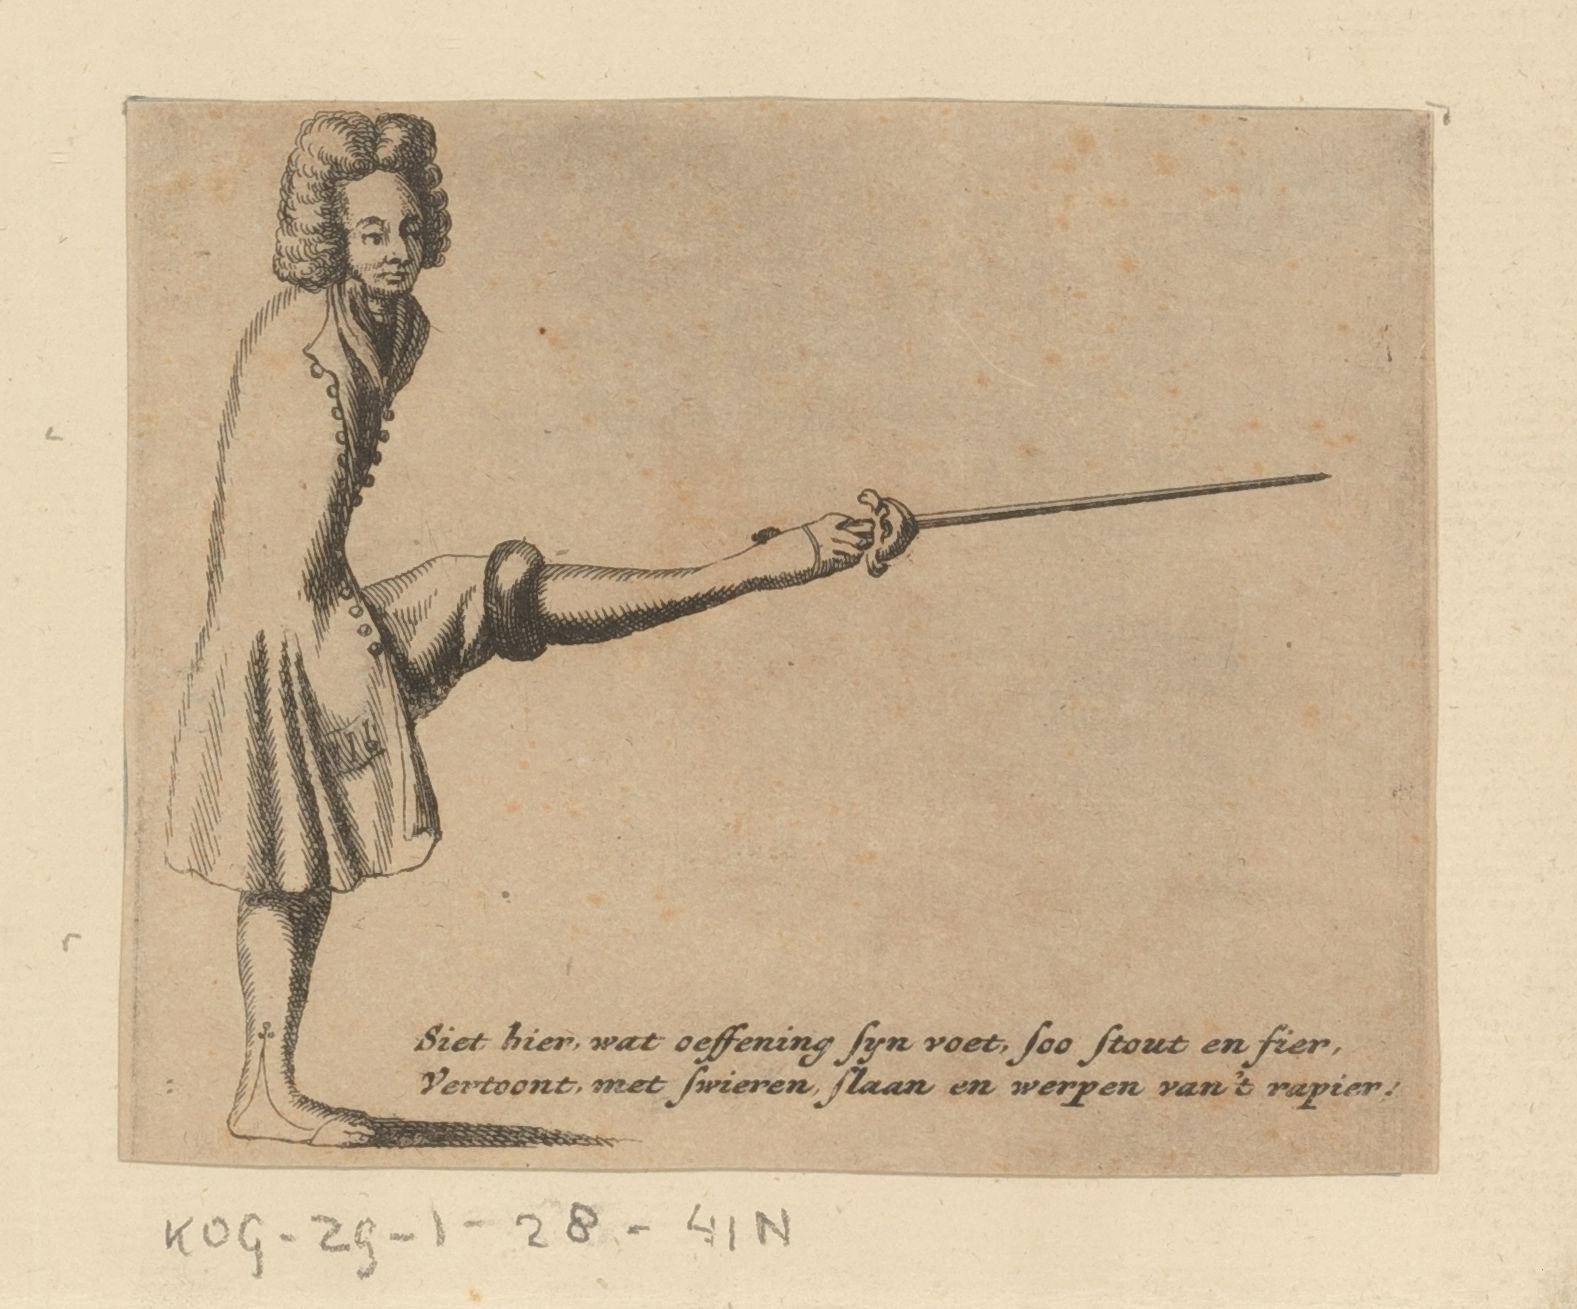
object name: print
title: Valerius, een man zonder armen houdt een degen op met zijn voet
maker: Anonymous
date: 1700-1749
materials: paper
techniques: engraving, etching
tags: human monstrosities ~ freak show, hacking and thrusting weapons: rapier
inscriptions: collector's mark: Lugt 1641, stamp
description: Onder de voorstelling een tweeregelig vers. Onderwerpsrubrieken binnen de Atlas Zeden en Gewoonten: Zeden en Gewoonten in Engeren Zin. Volksleven. Volksfeesten. Kermistypen, wondermenschen en dergelijken.